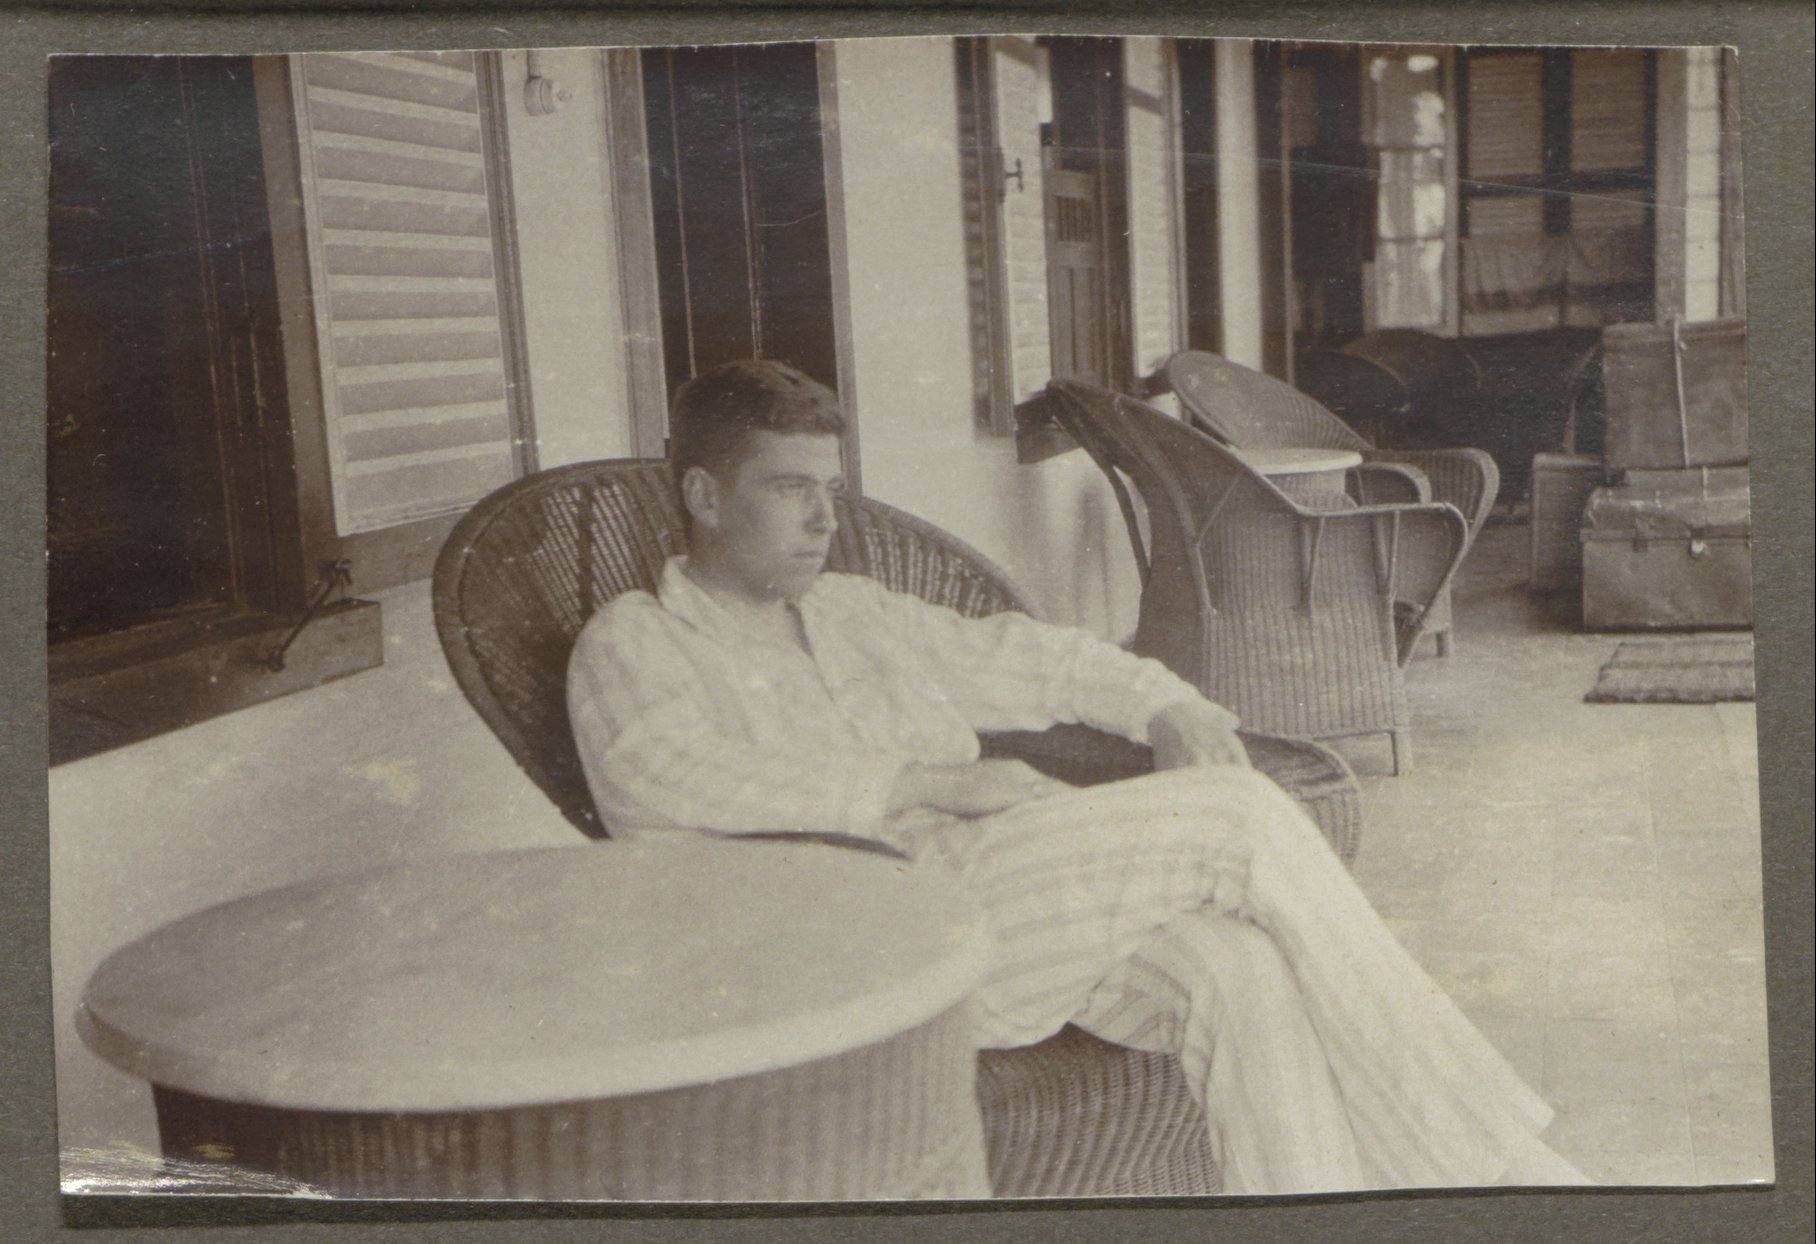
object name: photograph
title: Man in een pyjama zittend in een rieten stoel op een veranda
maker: Anonymous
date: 1920-1930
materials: photographic support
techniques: collodion silver print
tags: sun-porch, sun-parlour, glazed verandah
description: Onderdeel van familiealbum Nederlands-Indië.